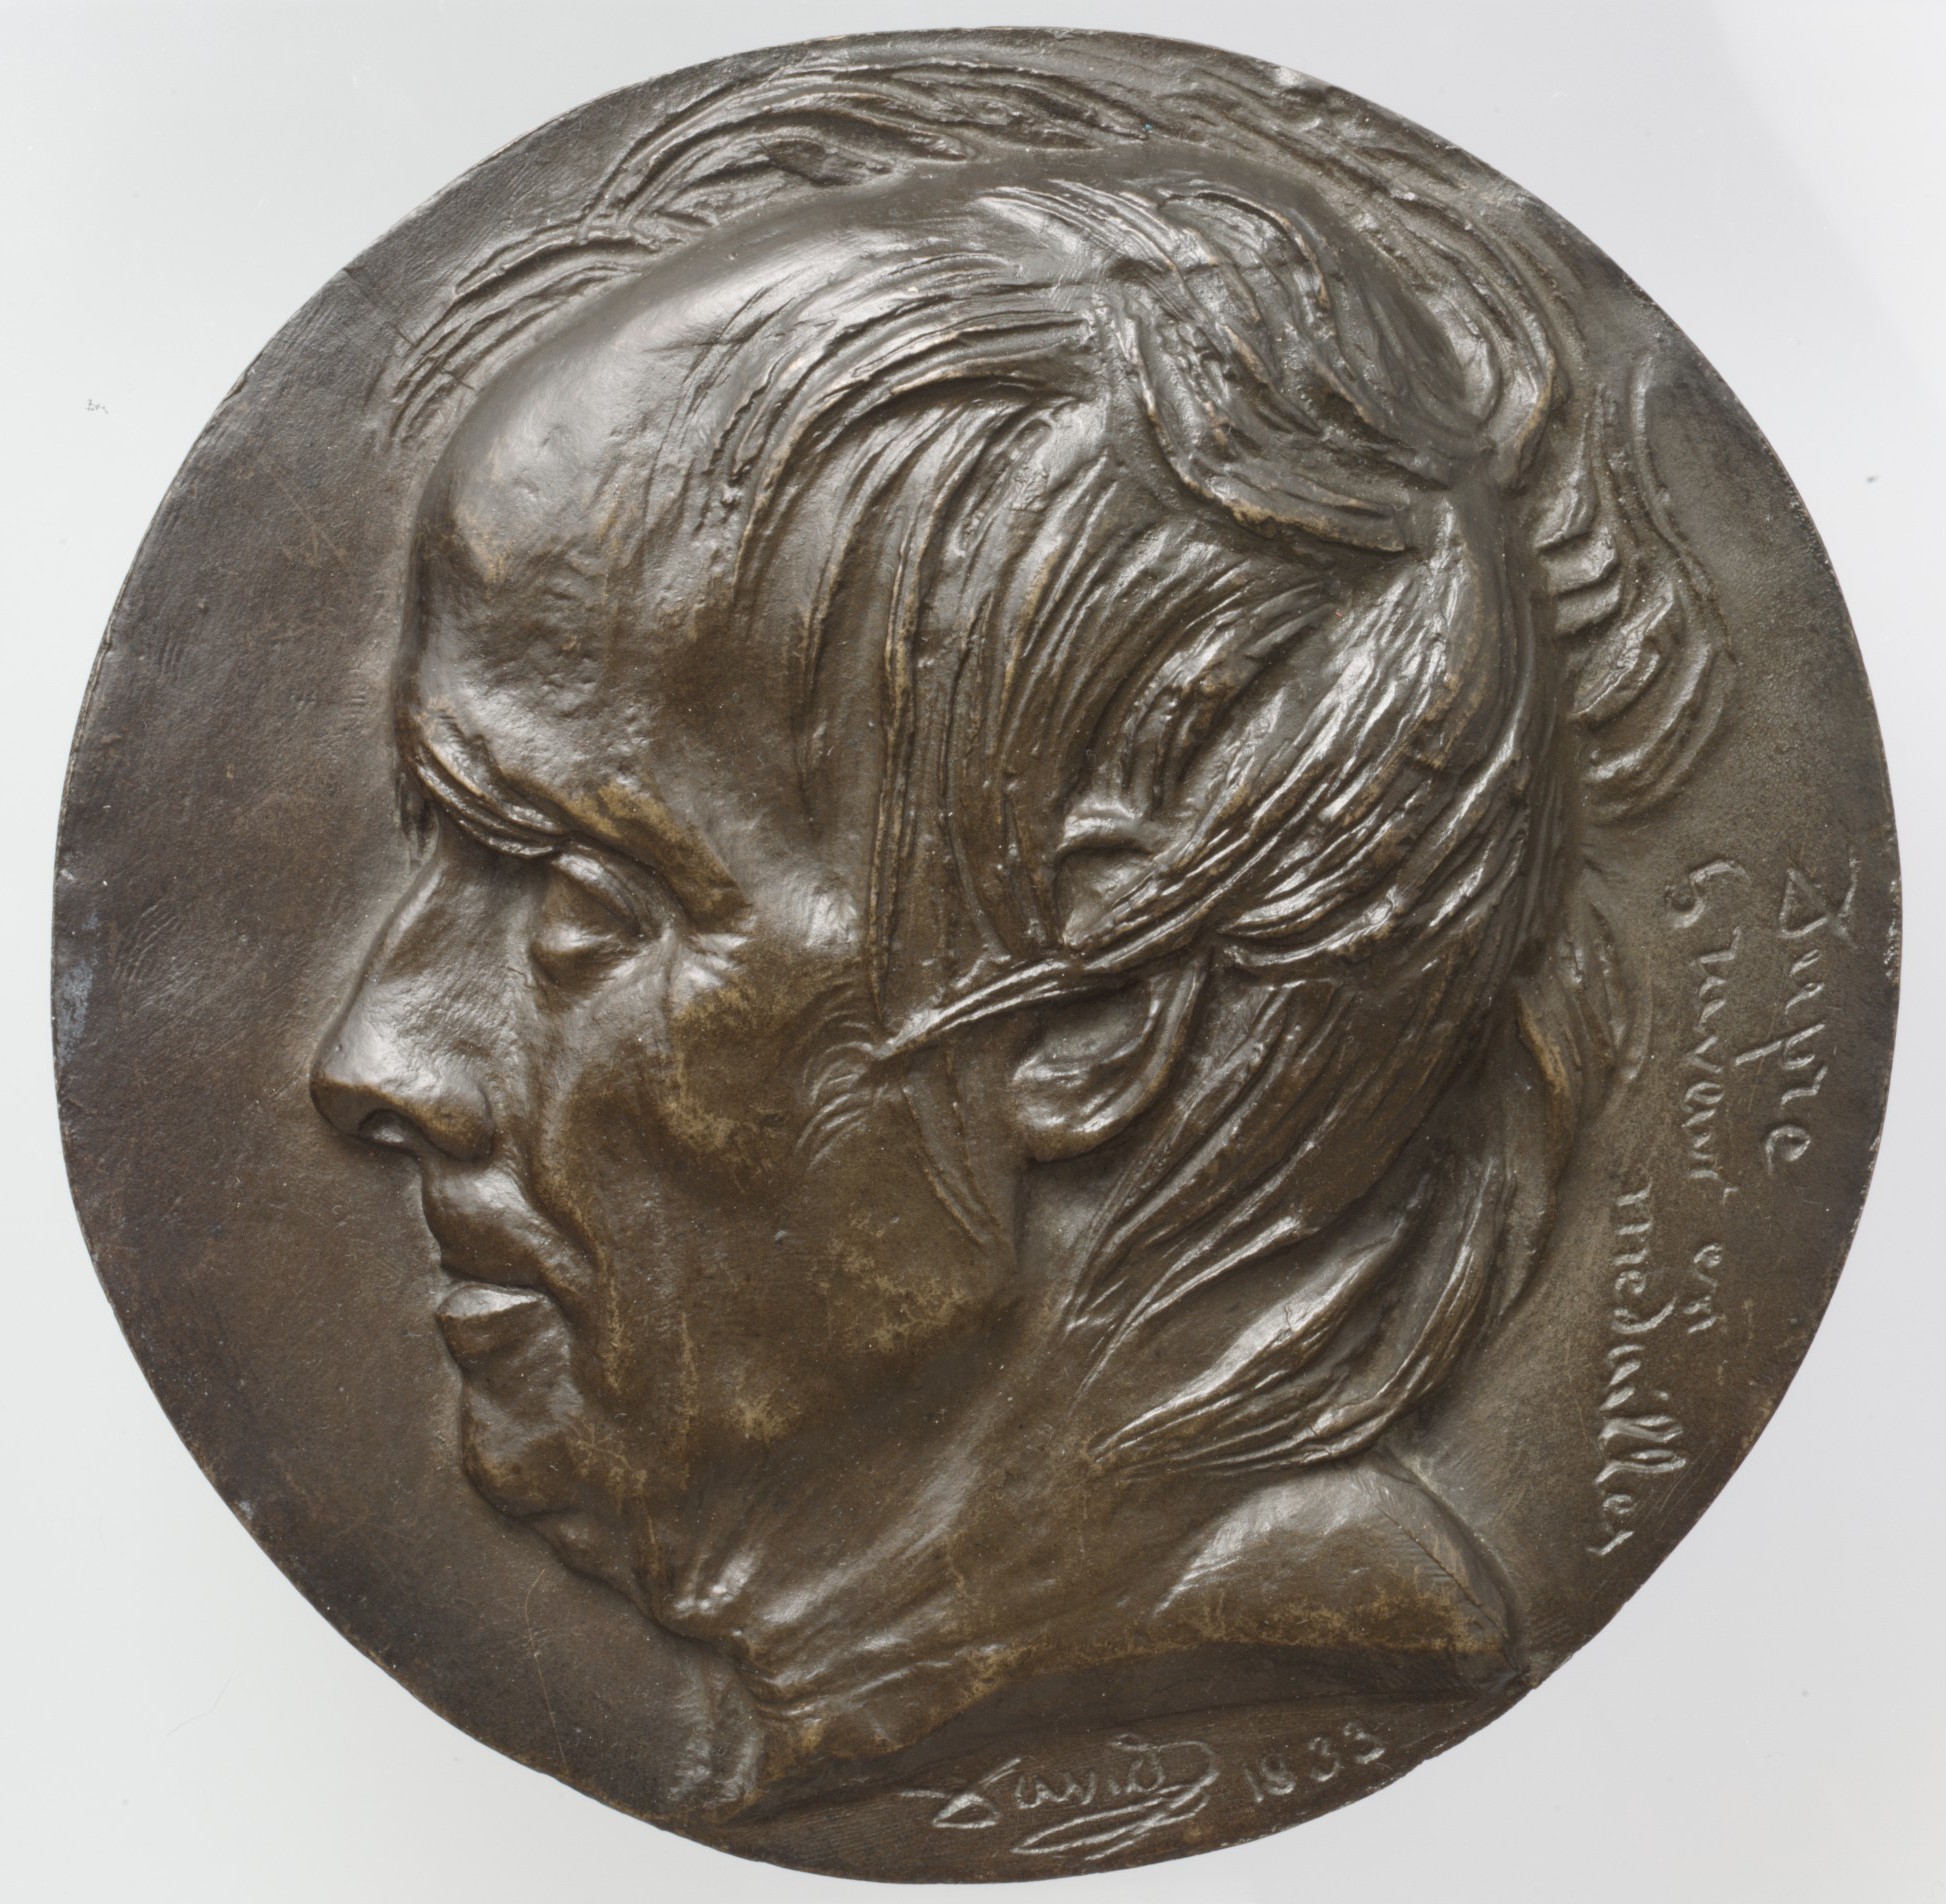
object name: medallion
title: Augustin Dupré (1748–1833)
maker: pierre jean david d'angers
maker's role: artist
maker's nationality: french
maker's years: 1788-1856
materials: bronze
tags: men,profiles